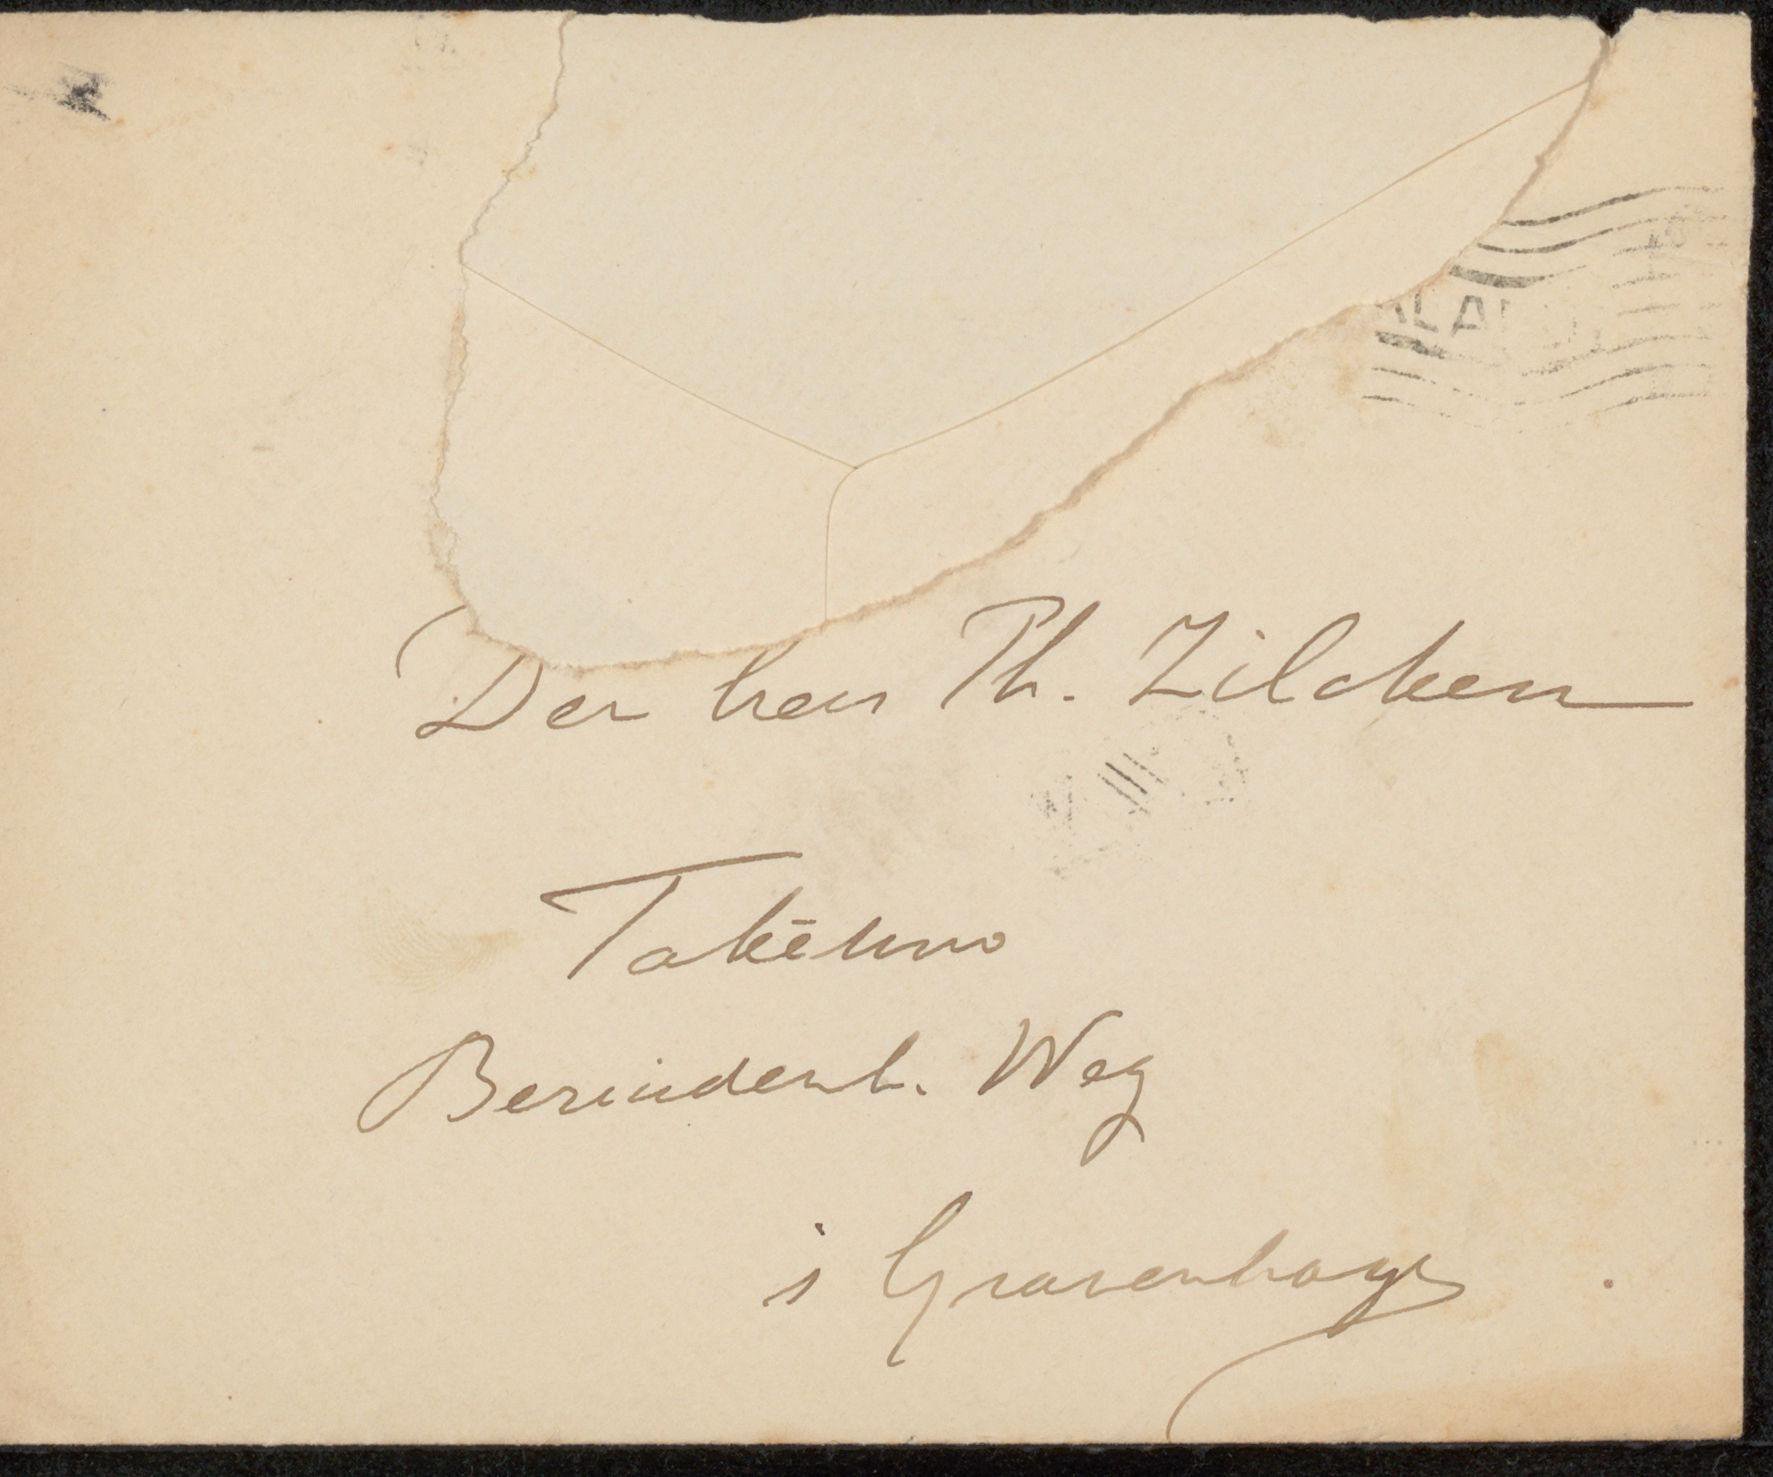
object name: envelope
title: Envelop aan Philip Zilcken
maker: suze groshans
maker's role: schrijver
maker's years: 1863-1944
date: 1873-1930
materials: ink, paper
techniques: pen, writing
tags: the hague, painter, draughtsman, philip zilcken